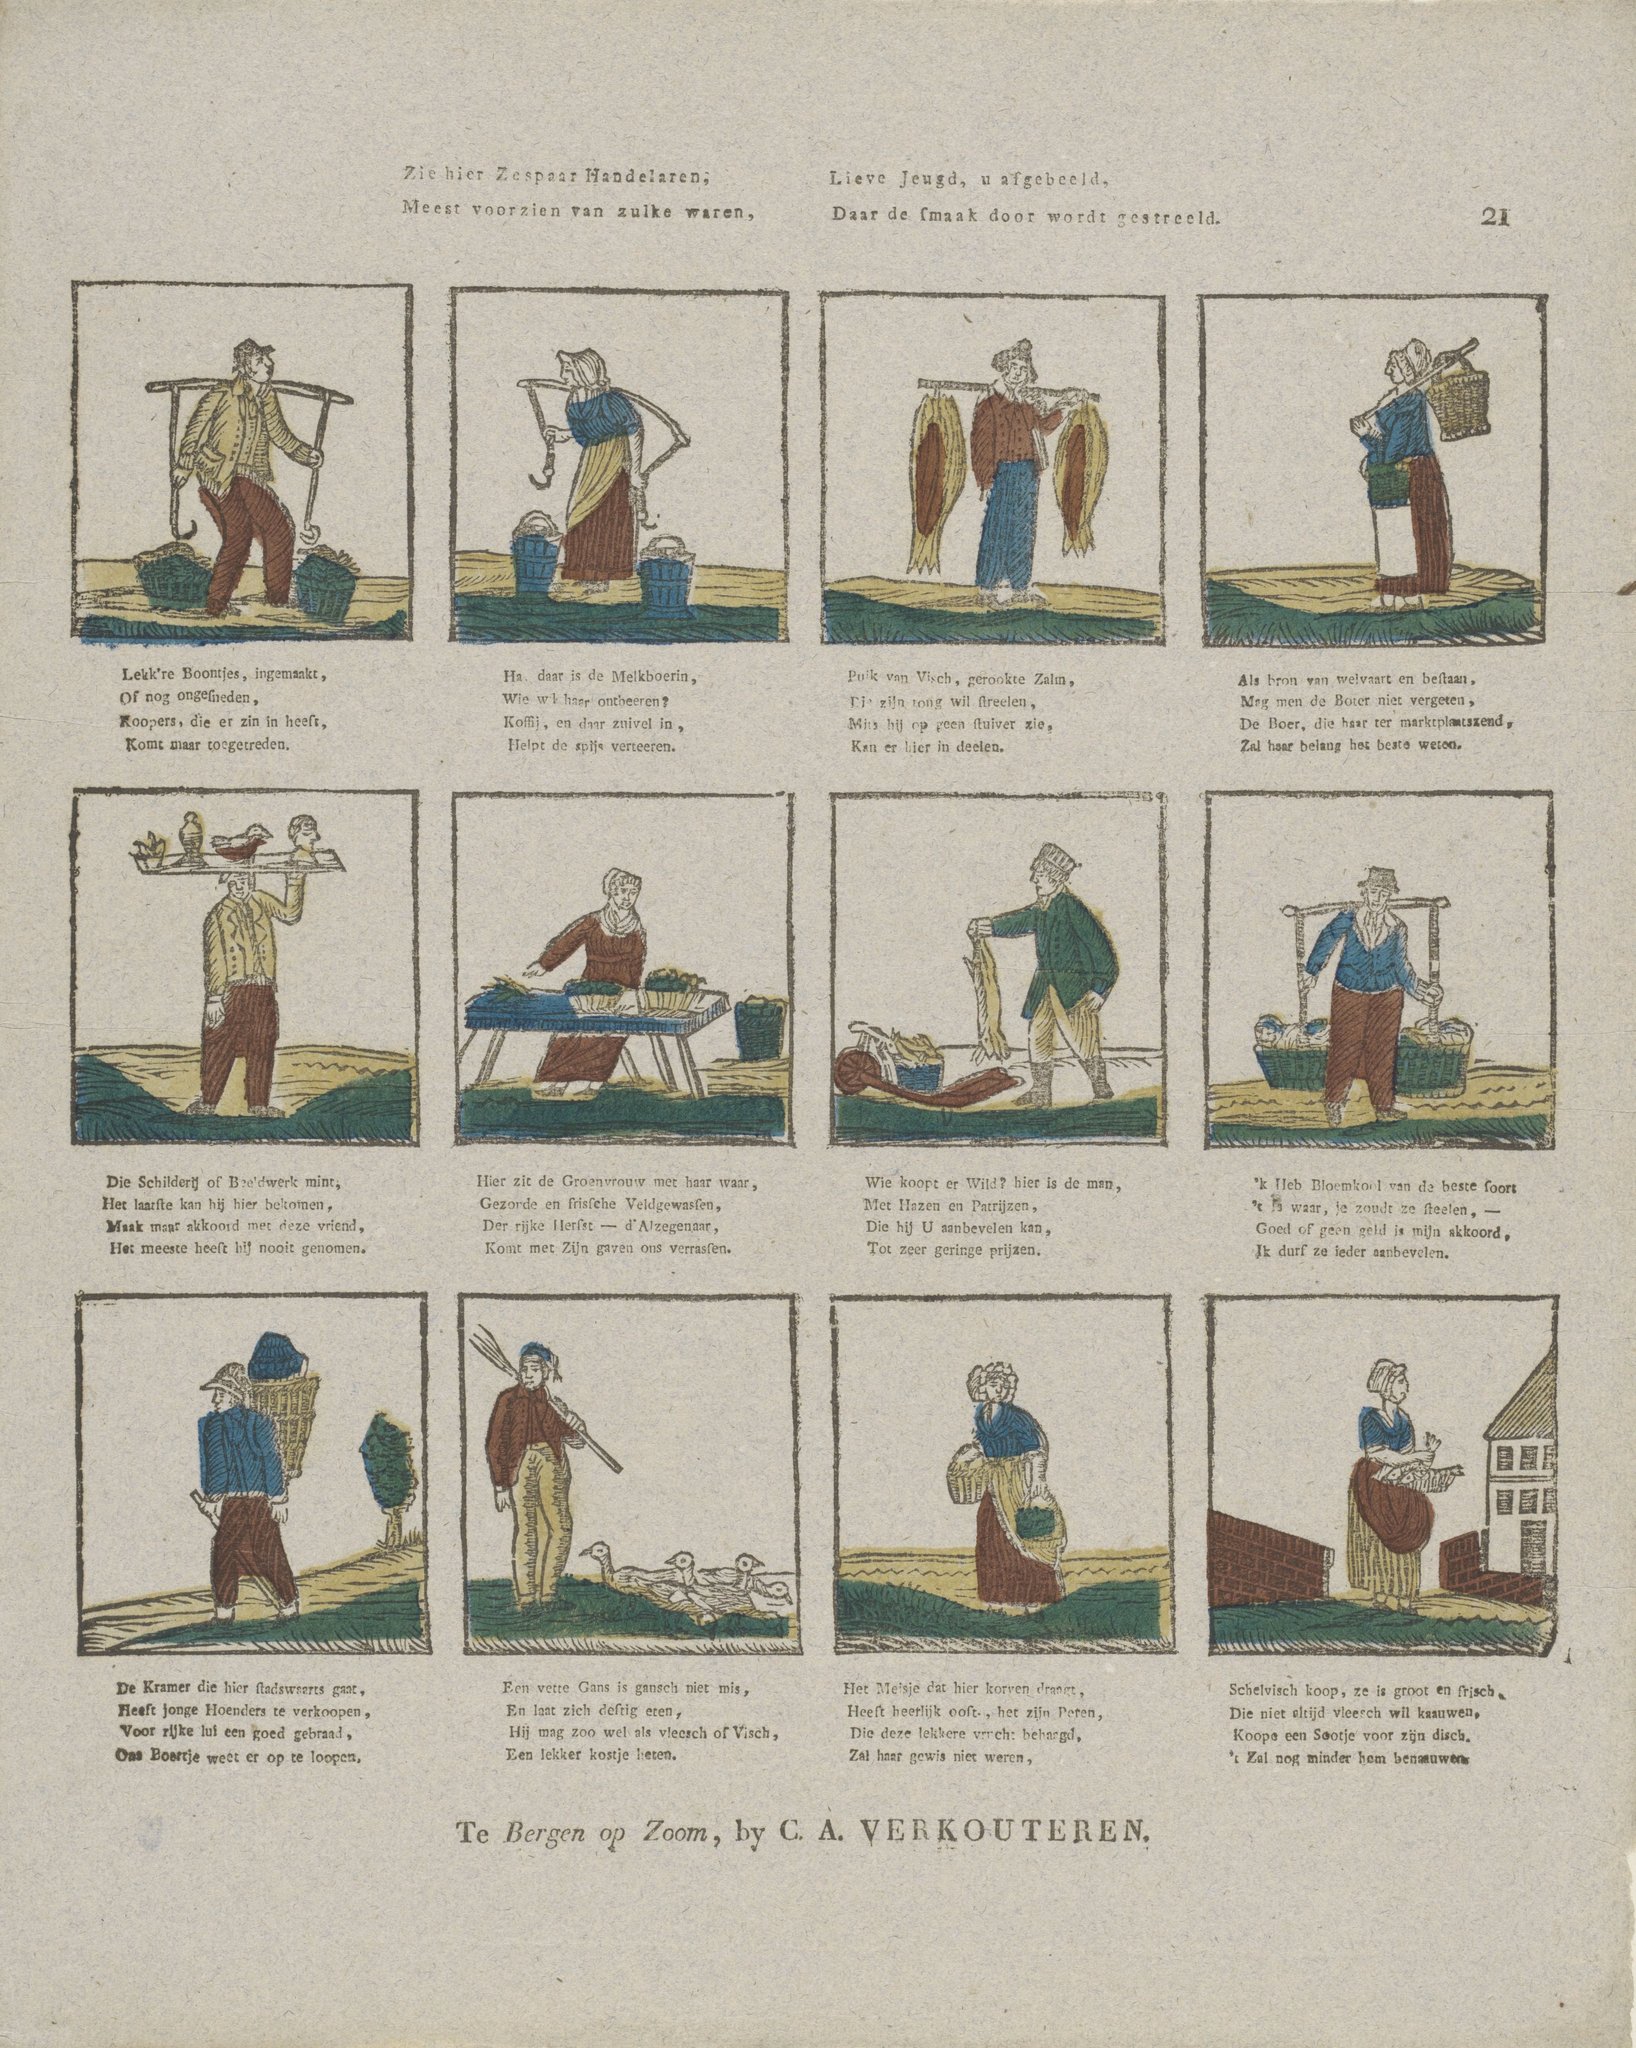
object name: popular print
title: Zie hier zespaar handelaren, / Meest voorzien van zulke waren, / Lieve jeugd, u afgebeeld, / Daar de smaak door wordt gestreeld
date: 1700-1899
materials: paper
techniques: colour, letterpress printing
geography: bergen op zoom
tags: street-trader, merchant, salesman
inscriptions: collector's mark: Lugt 2760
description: Blad met 12 voorstellingen van straatverkopers. Onder elke voorstelling een vierregelig vers. Genummerd rechtsboven: 21.